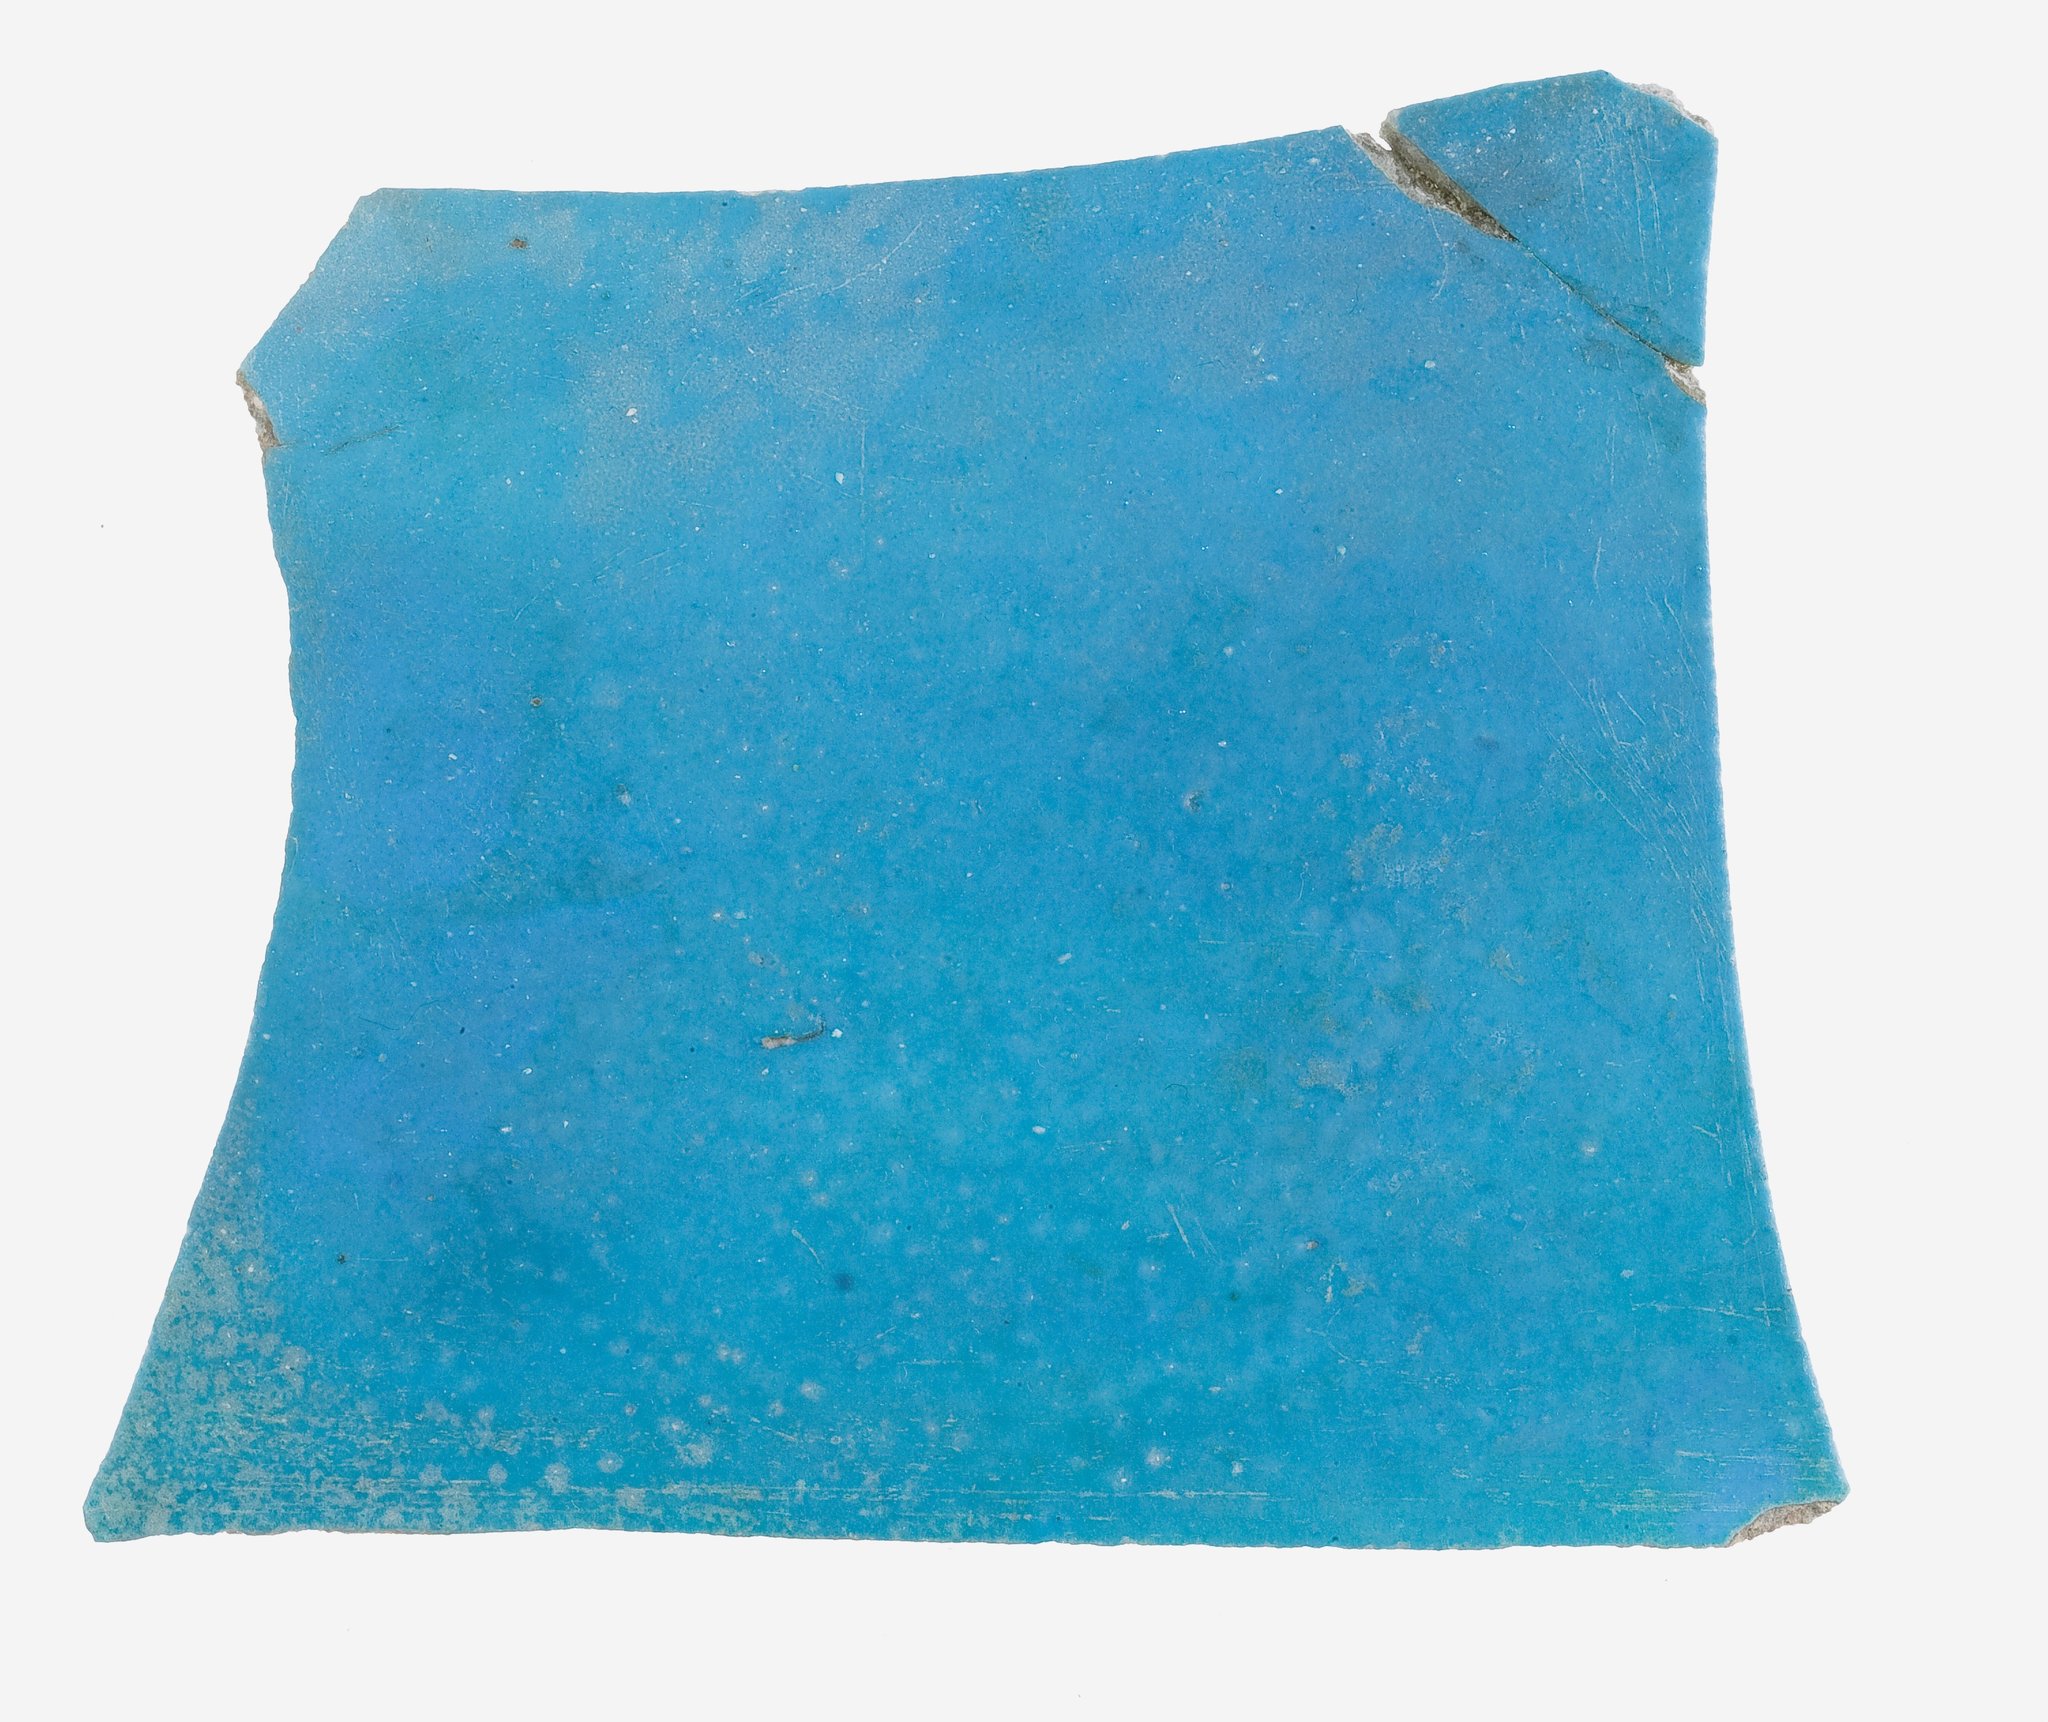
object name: tile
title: Square Wall Tile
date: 1390-1352 BCE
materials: faience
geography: egypt